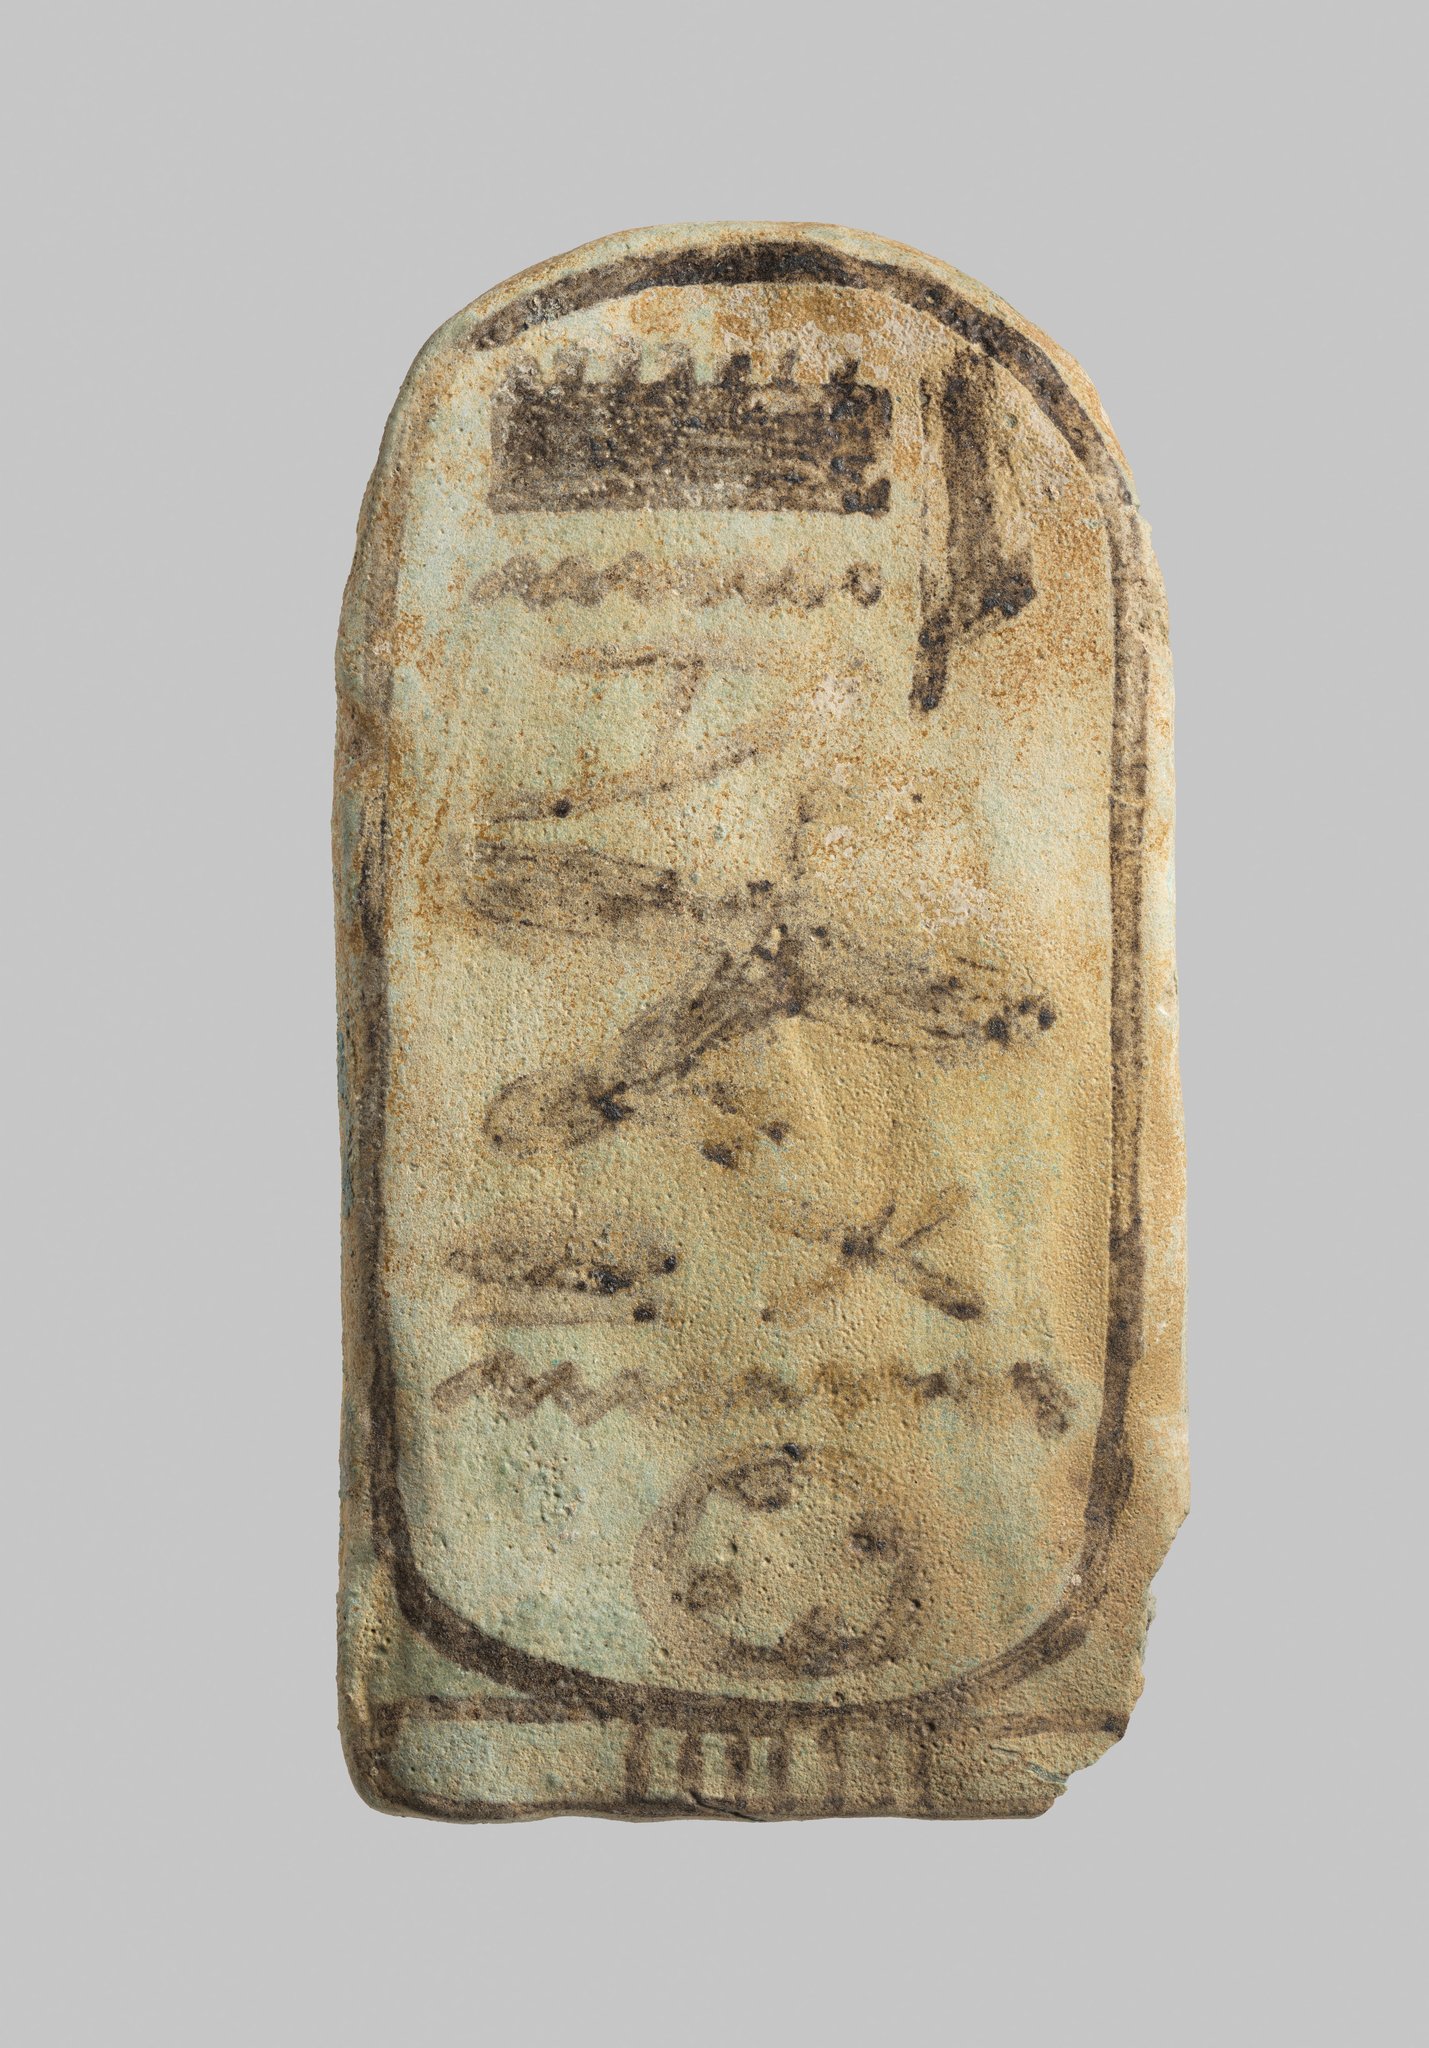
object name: foundation plaque, psusennes i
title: Foundation plaque inscribed with the cartouche of Psusennes I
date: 1040-992 BCE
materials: faience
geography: eastern delta